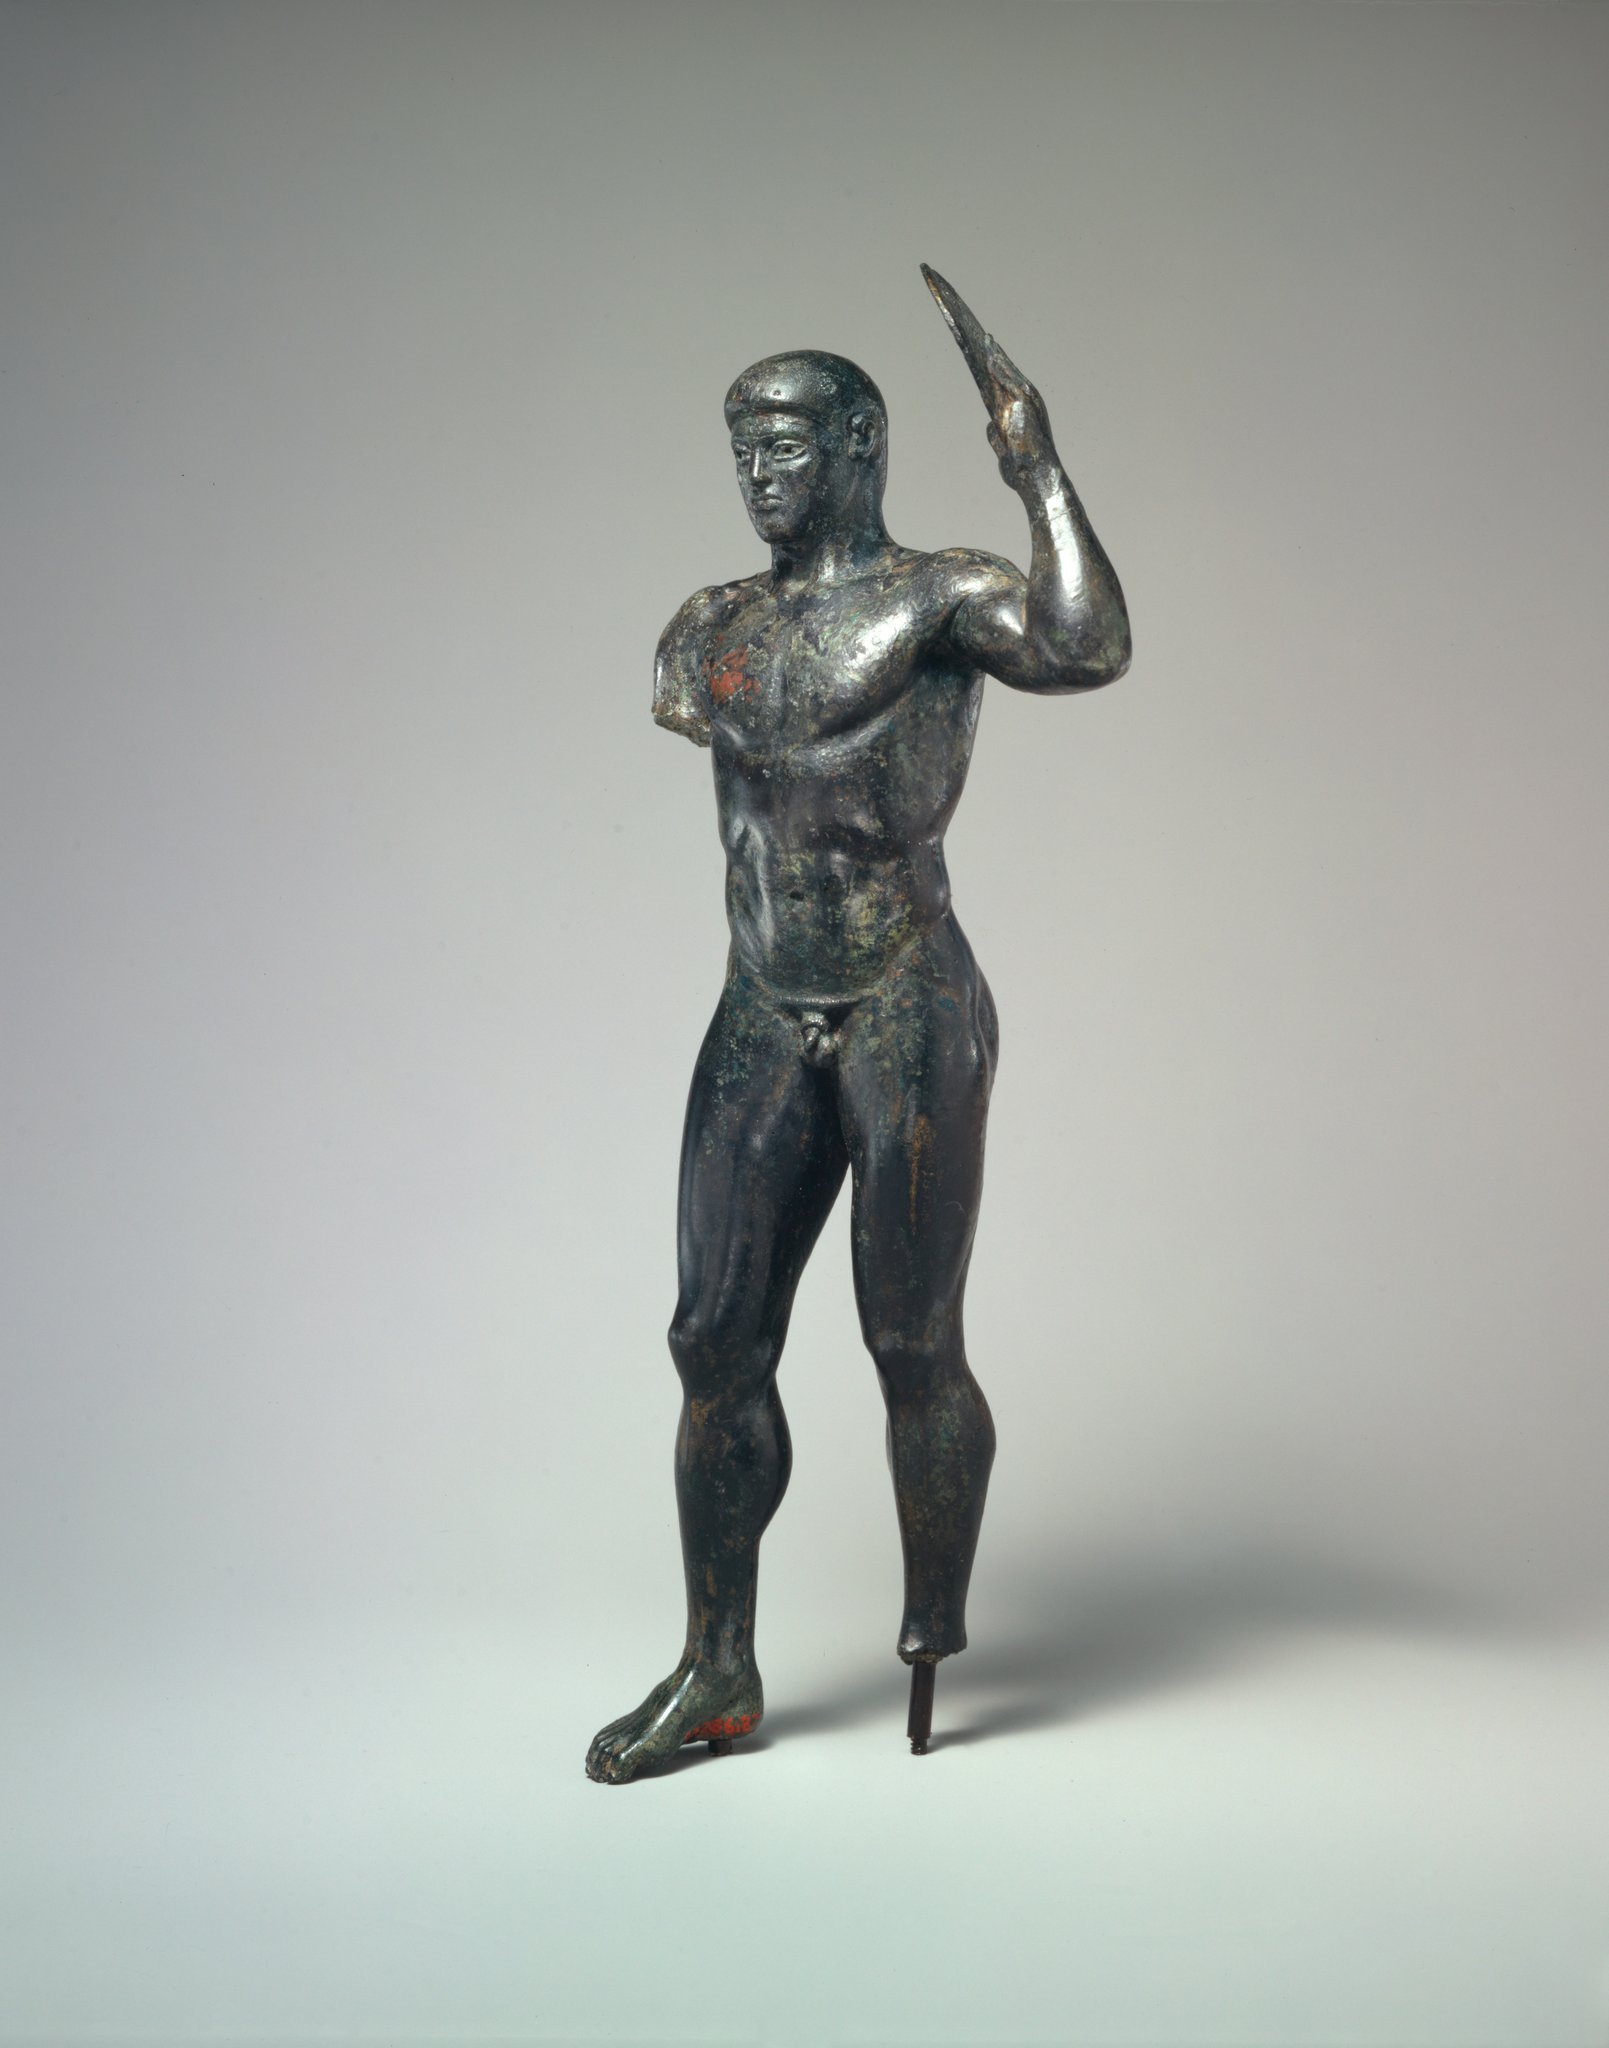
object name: statuette of a diskos thrower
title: Bronze diskos thrower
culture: greek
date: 480-460 BCE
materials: bronze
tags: male nudes,athletes